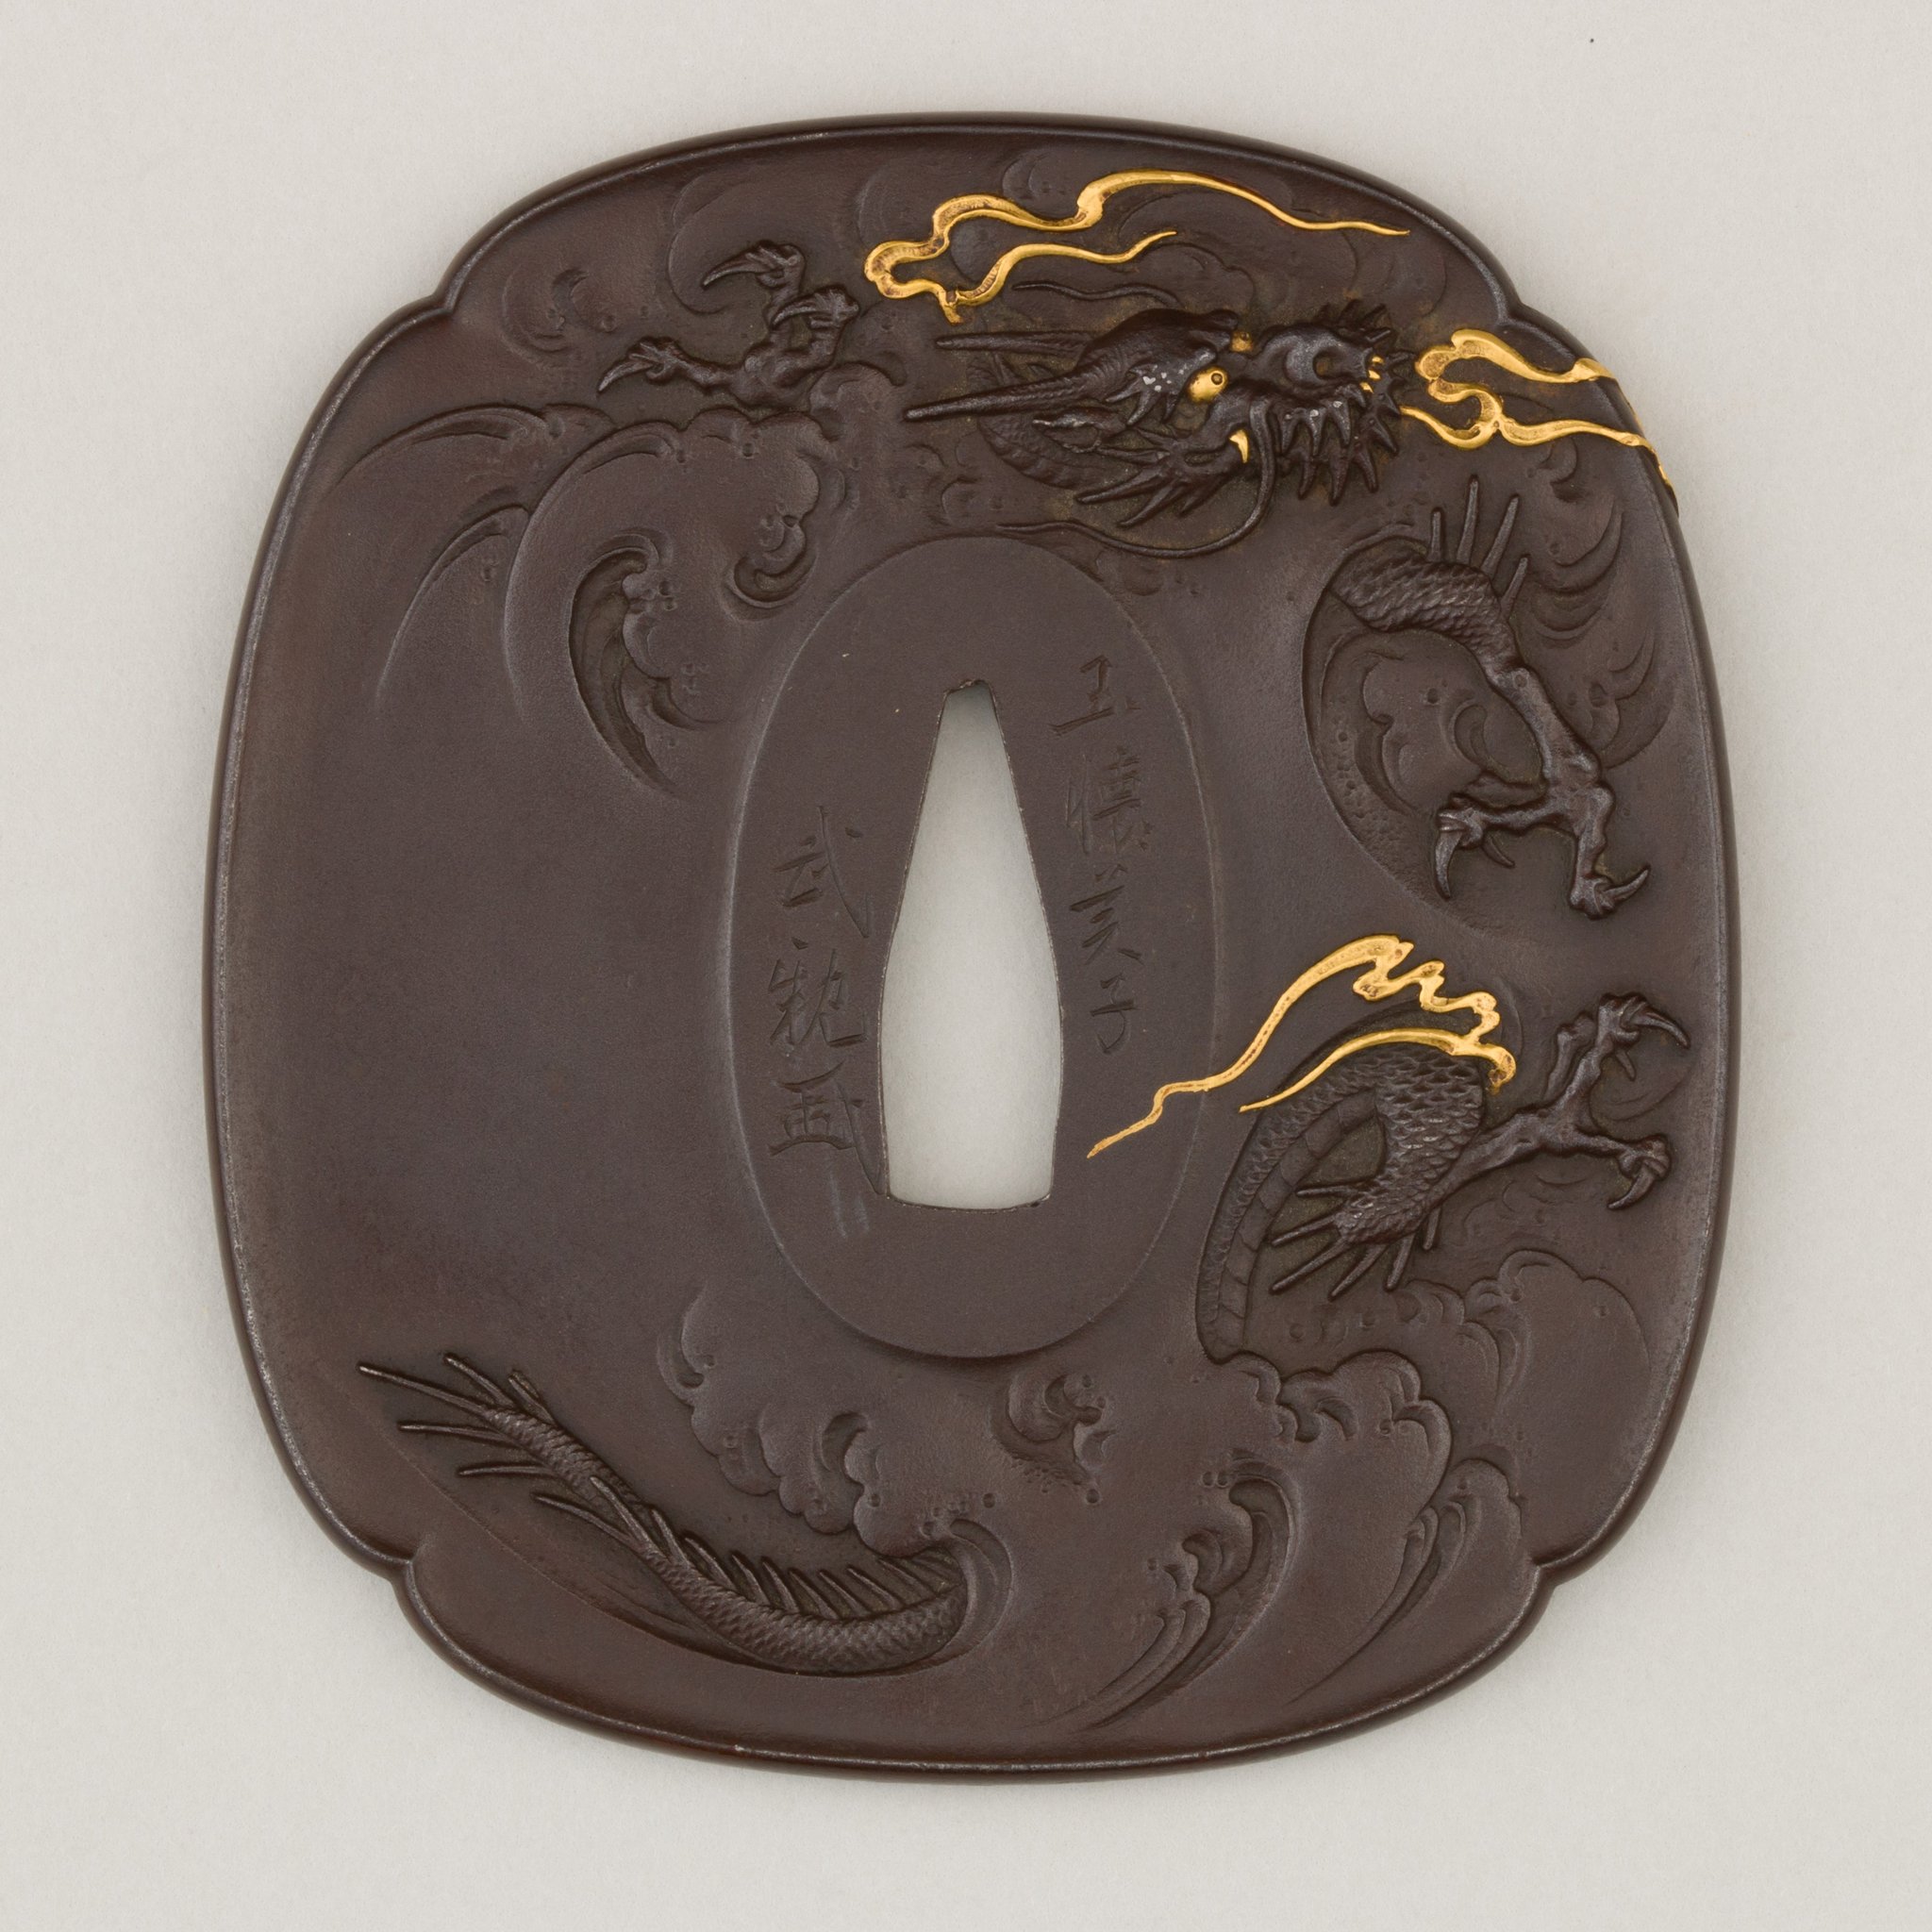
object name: sword guard tsuba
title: Sword Guard (Tsuba)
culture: japanese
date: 1834-1866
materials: copper, gold, iron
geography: japan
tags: dragons